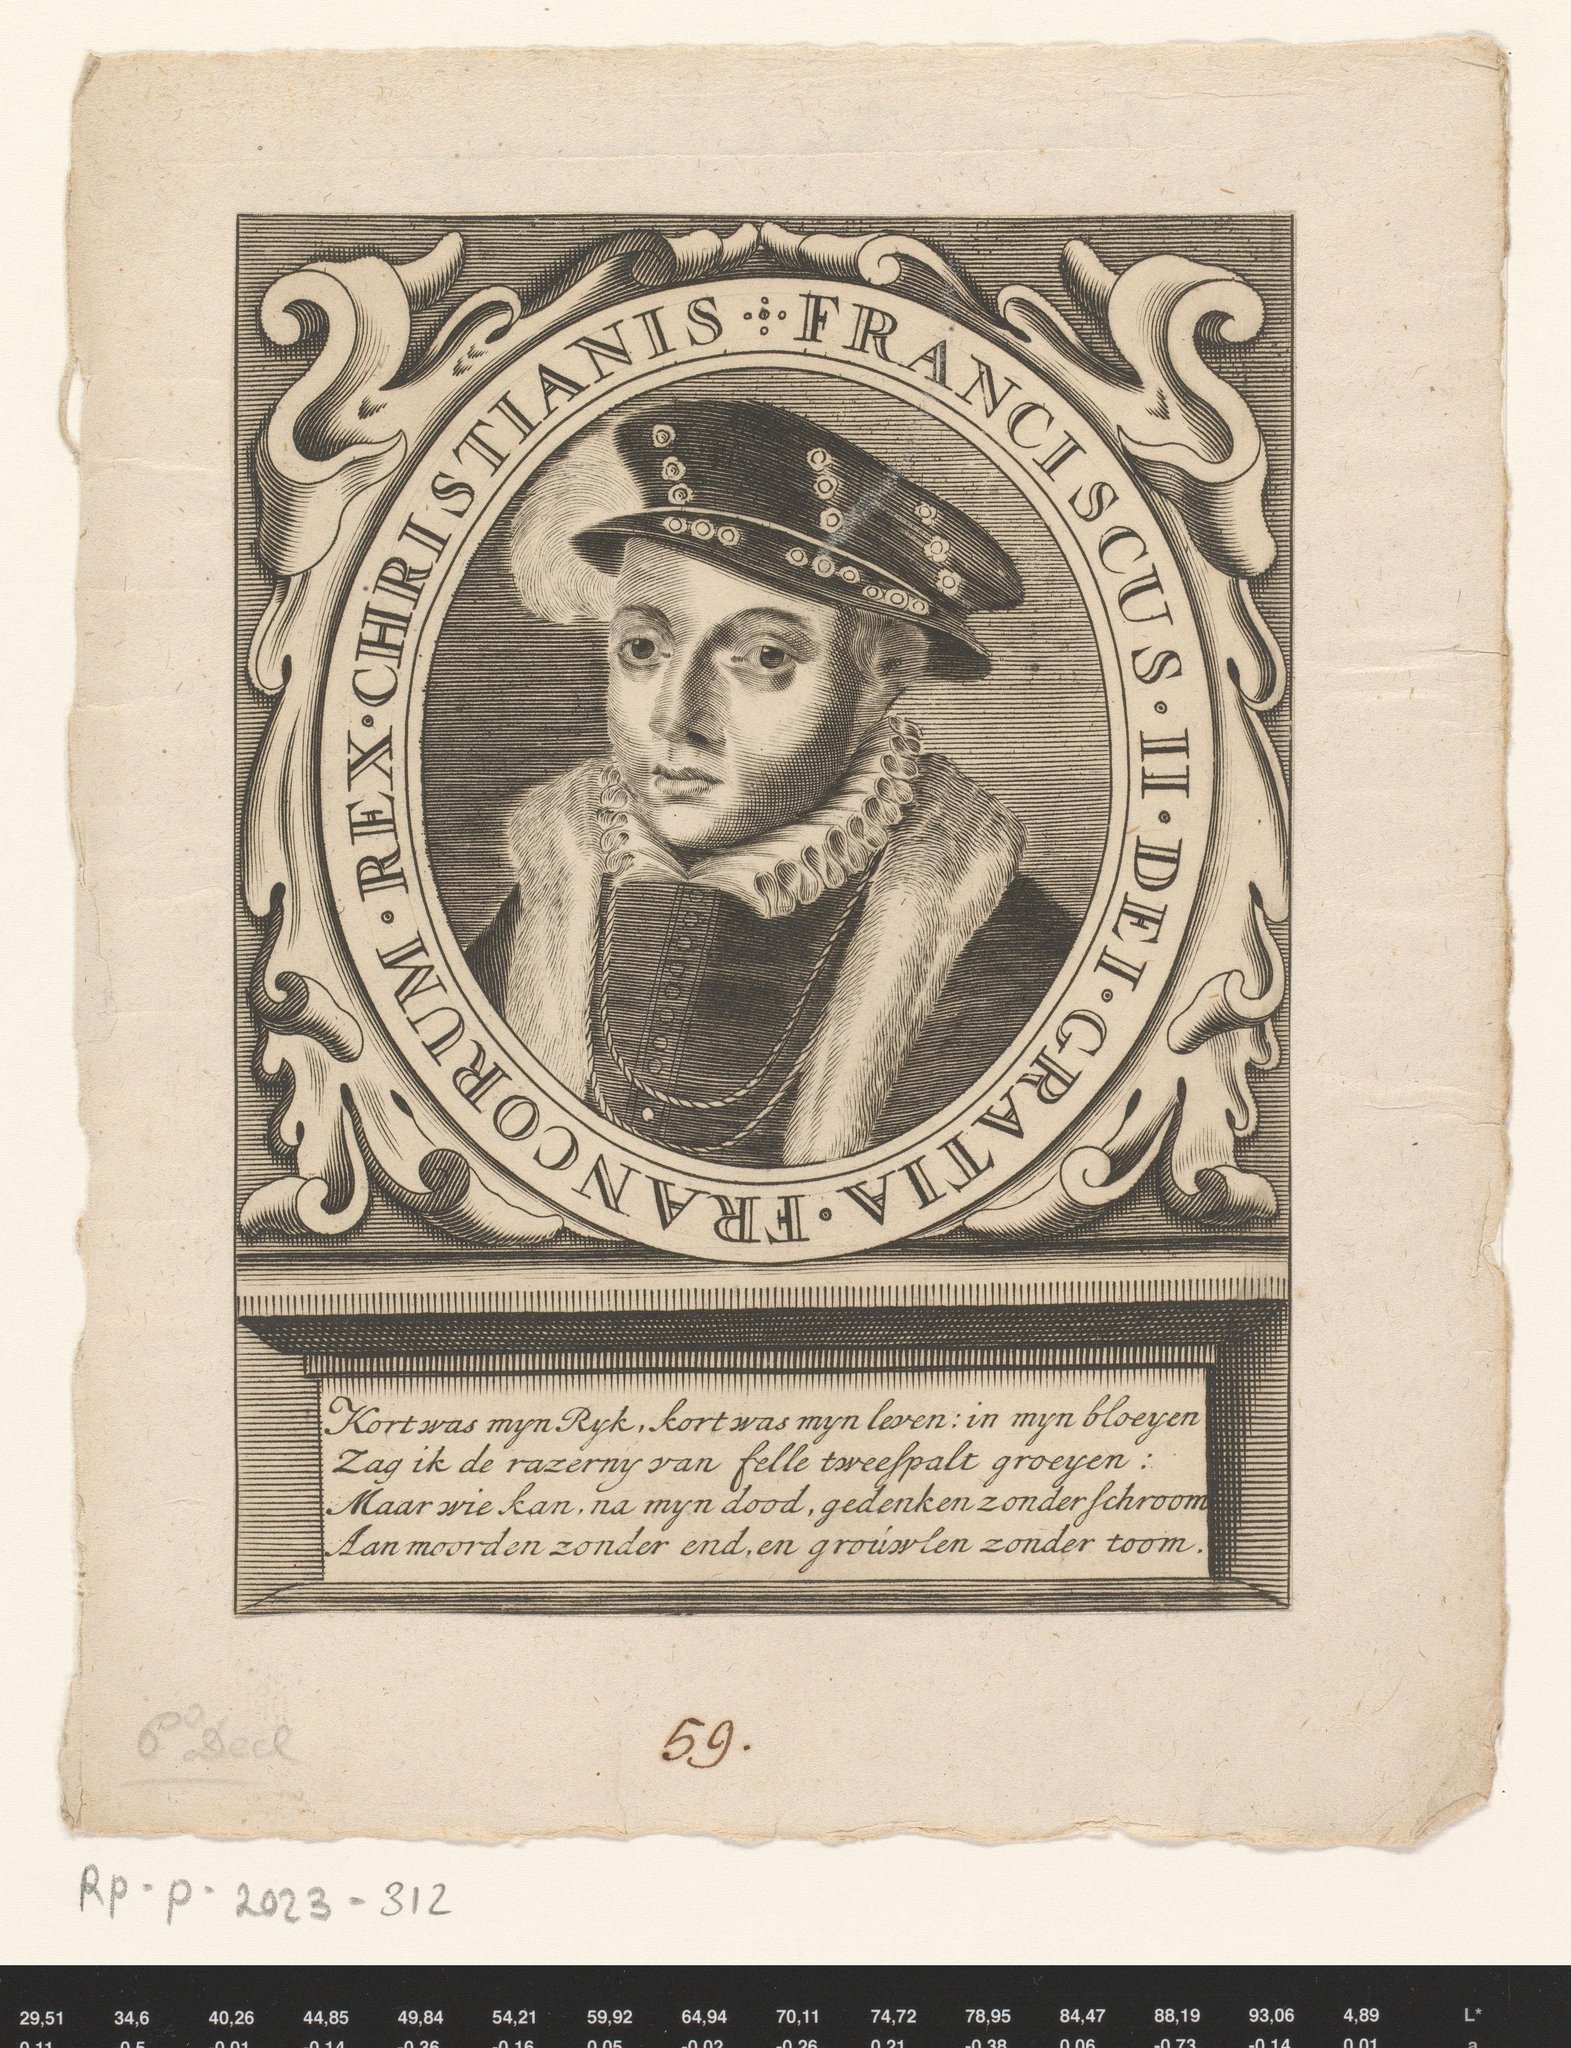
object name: book illustration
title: Portret van Frans II van Frankrijk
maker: Anonymous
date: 1685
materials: paper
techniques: engraving, etching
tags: paris, historical persons, king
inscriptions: collector's mark: Lugt 2228, number: ‘59.’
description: Prent waarschijnlijk uit: Mézeray, François Eudes de. Chronyk van Vrankryk. [Vertaald uit het Frans door] G. v. Broekhuizen. Amsterdam: Timotheus ten Hoorn en Jan Bouman, 1685, dl. 2, p. 321.